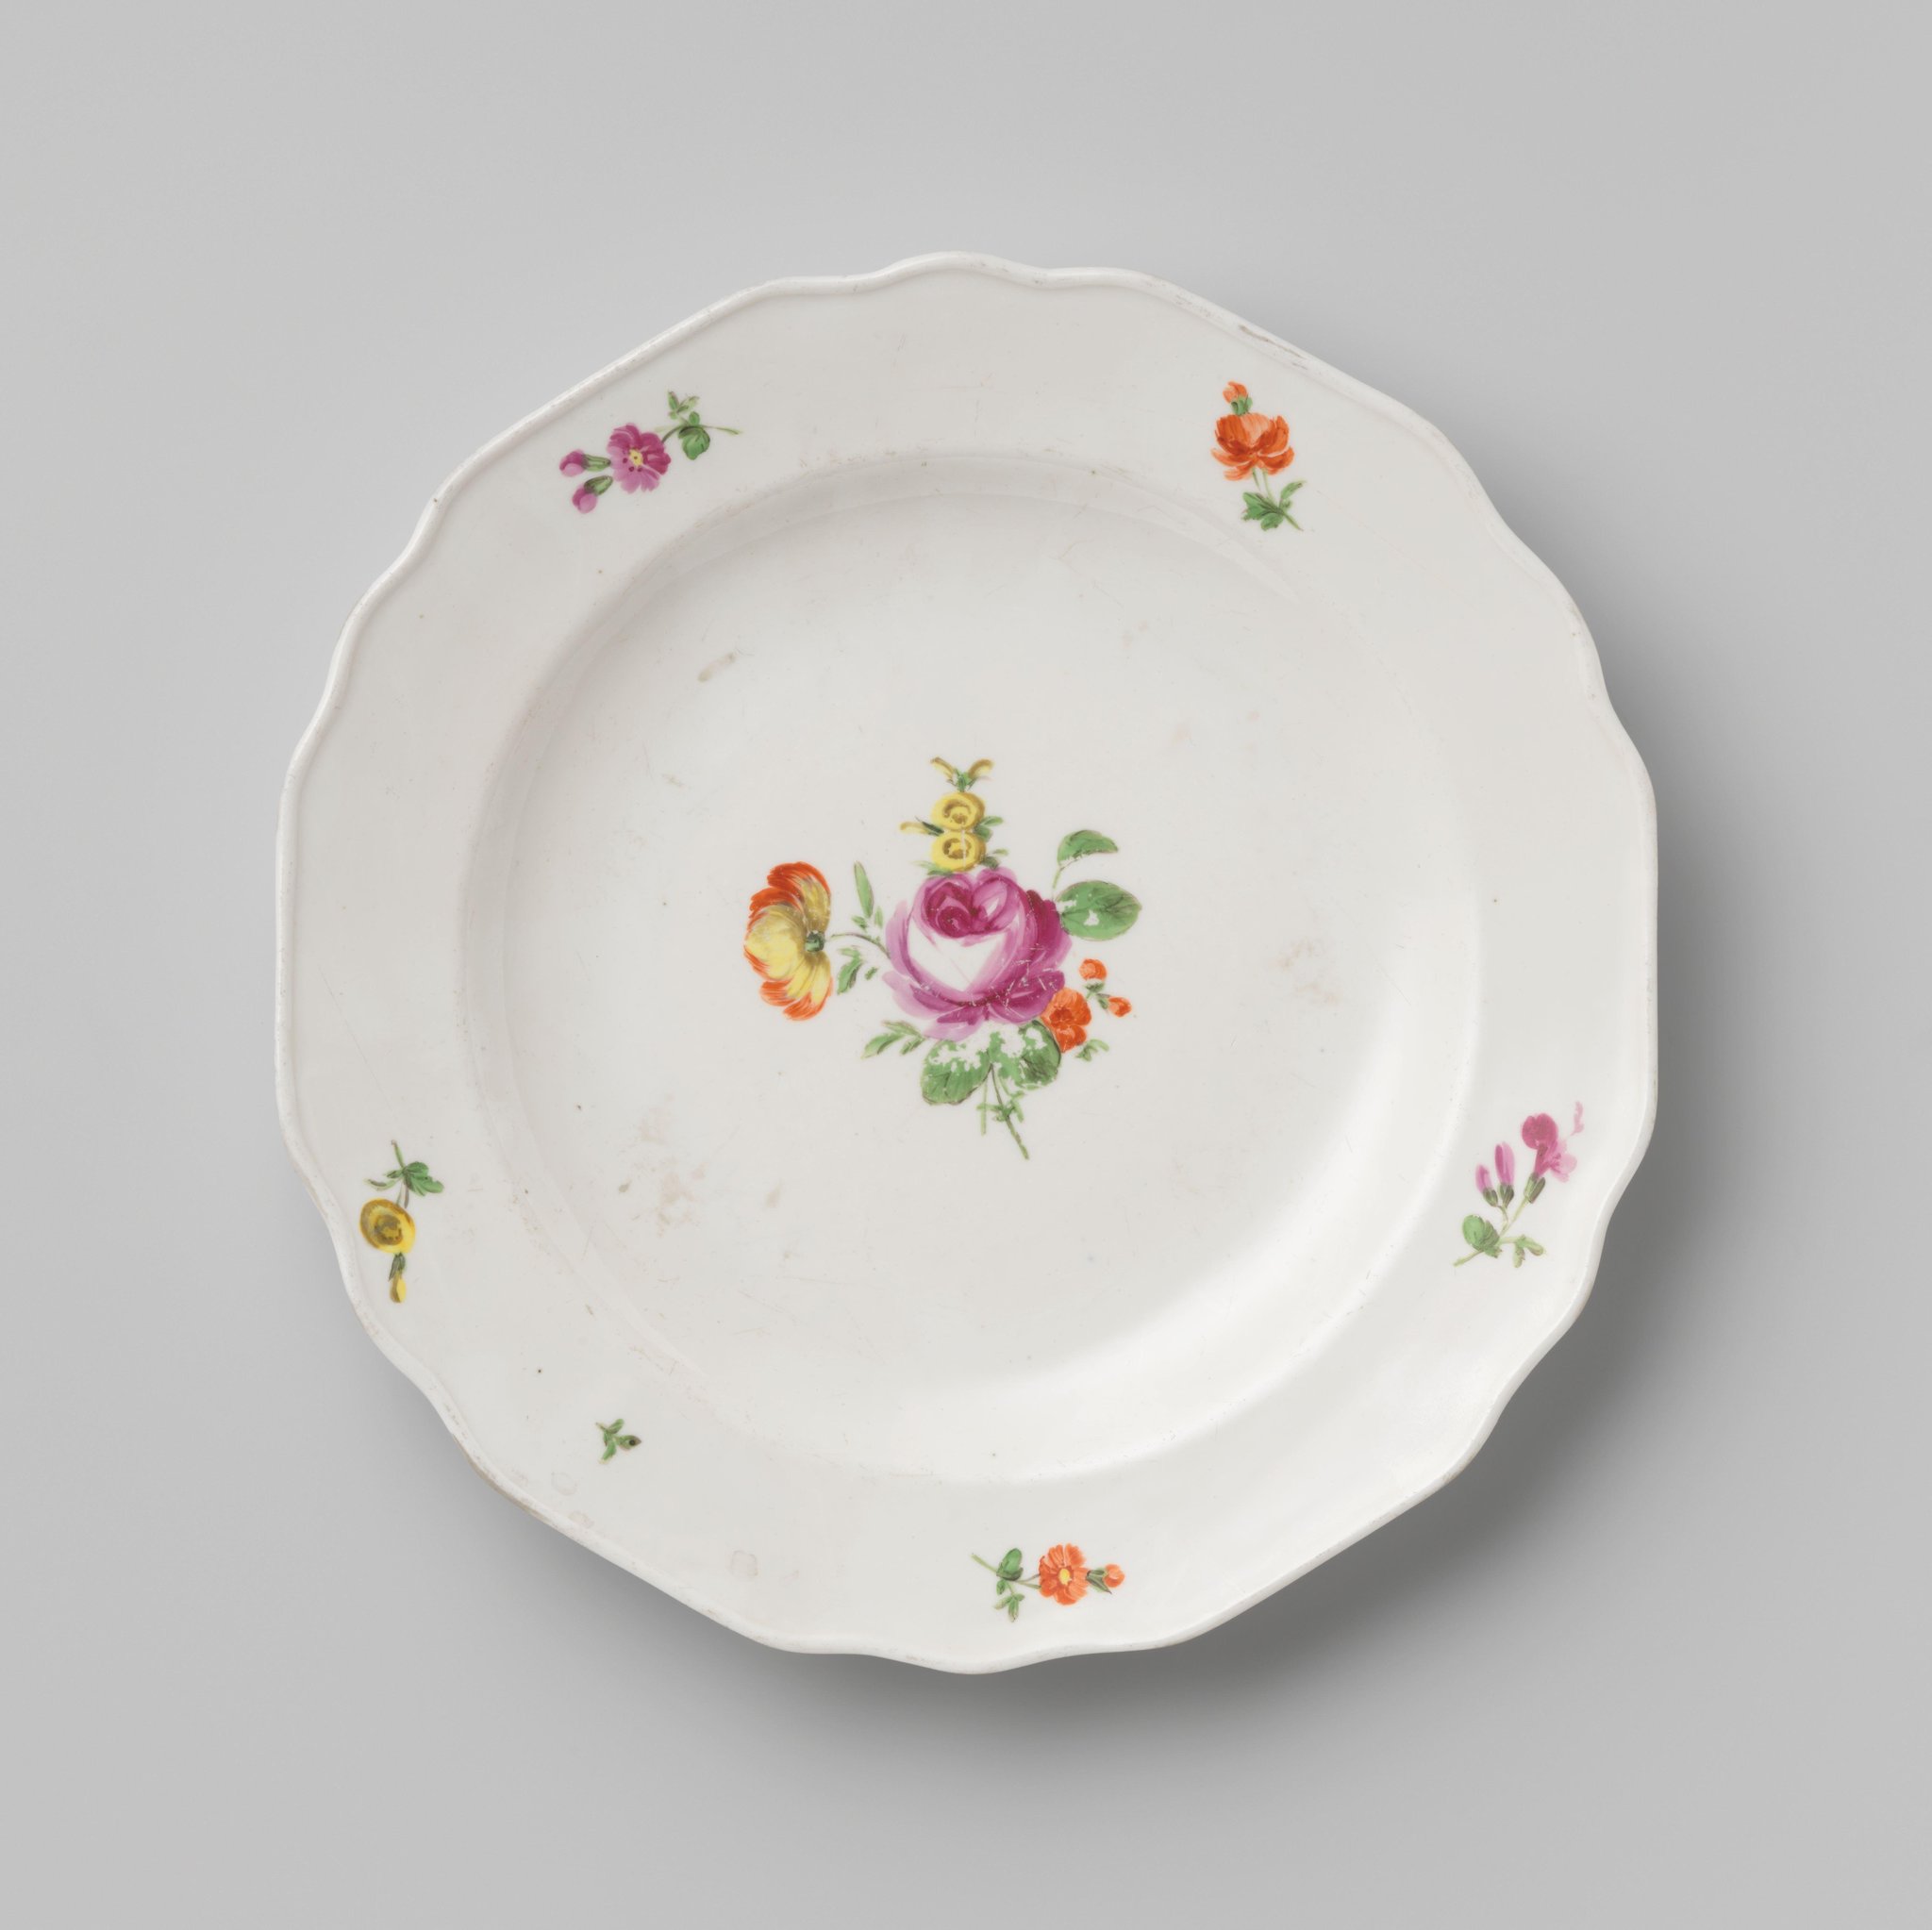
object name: service set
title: Plate with a bouquet and flower sprays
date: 1800-1849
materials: glaze, paint, porcelain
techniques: firing, forming, turning, vitrification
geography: vienna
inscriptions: mark: ‘schild/ P/ S/ 32/ 40/ 89’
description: Bord van porselein met een gelobde rand, beschilderd op het glazuur in rood, roze, groen en geel. Op het plat een boeket van verschillende bloemen (o.a. pioenroos) omgeven door losse takjes en op de rand vijf bloemtakken. Gemerkt op de onderzijde met het schild, de letters P, S en de nummers 32, 40 en 89. Op enkele plekken heeft het email losgelaten.